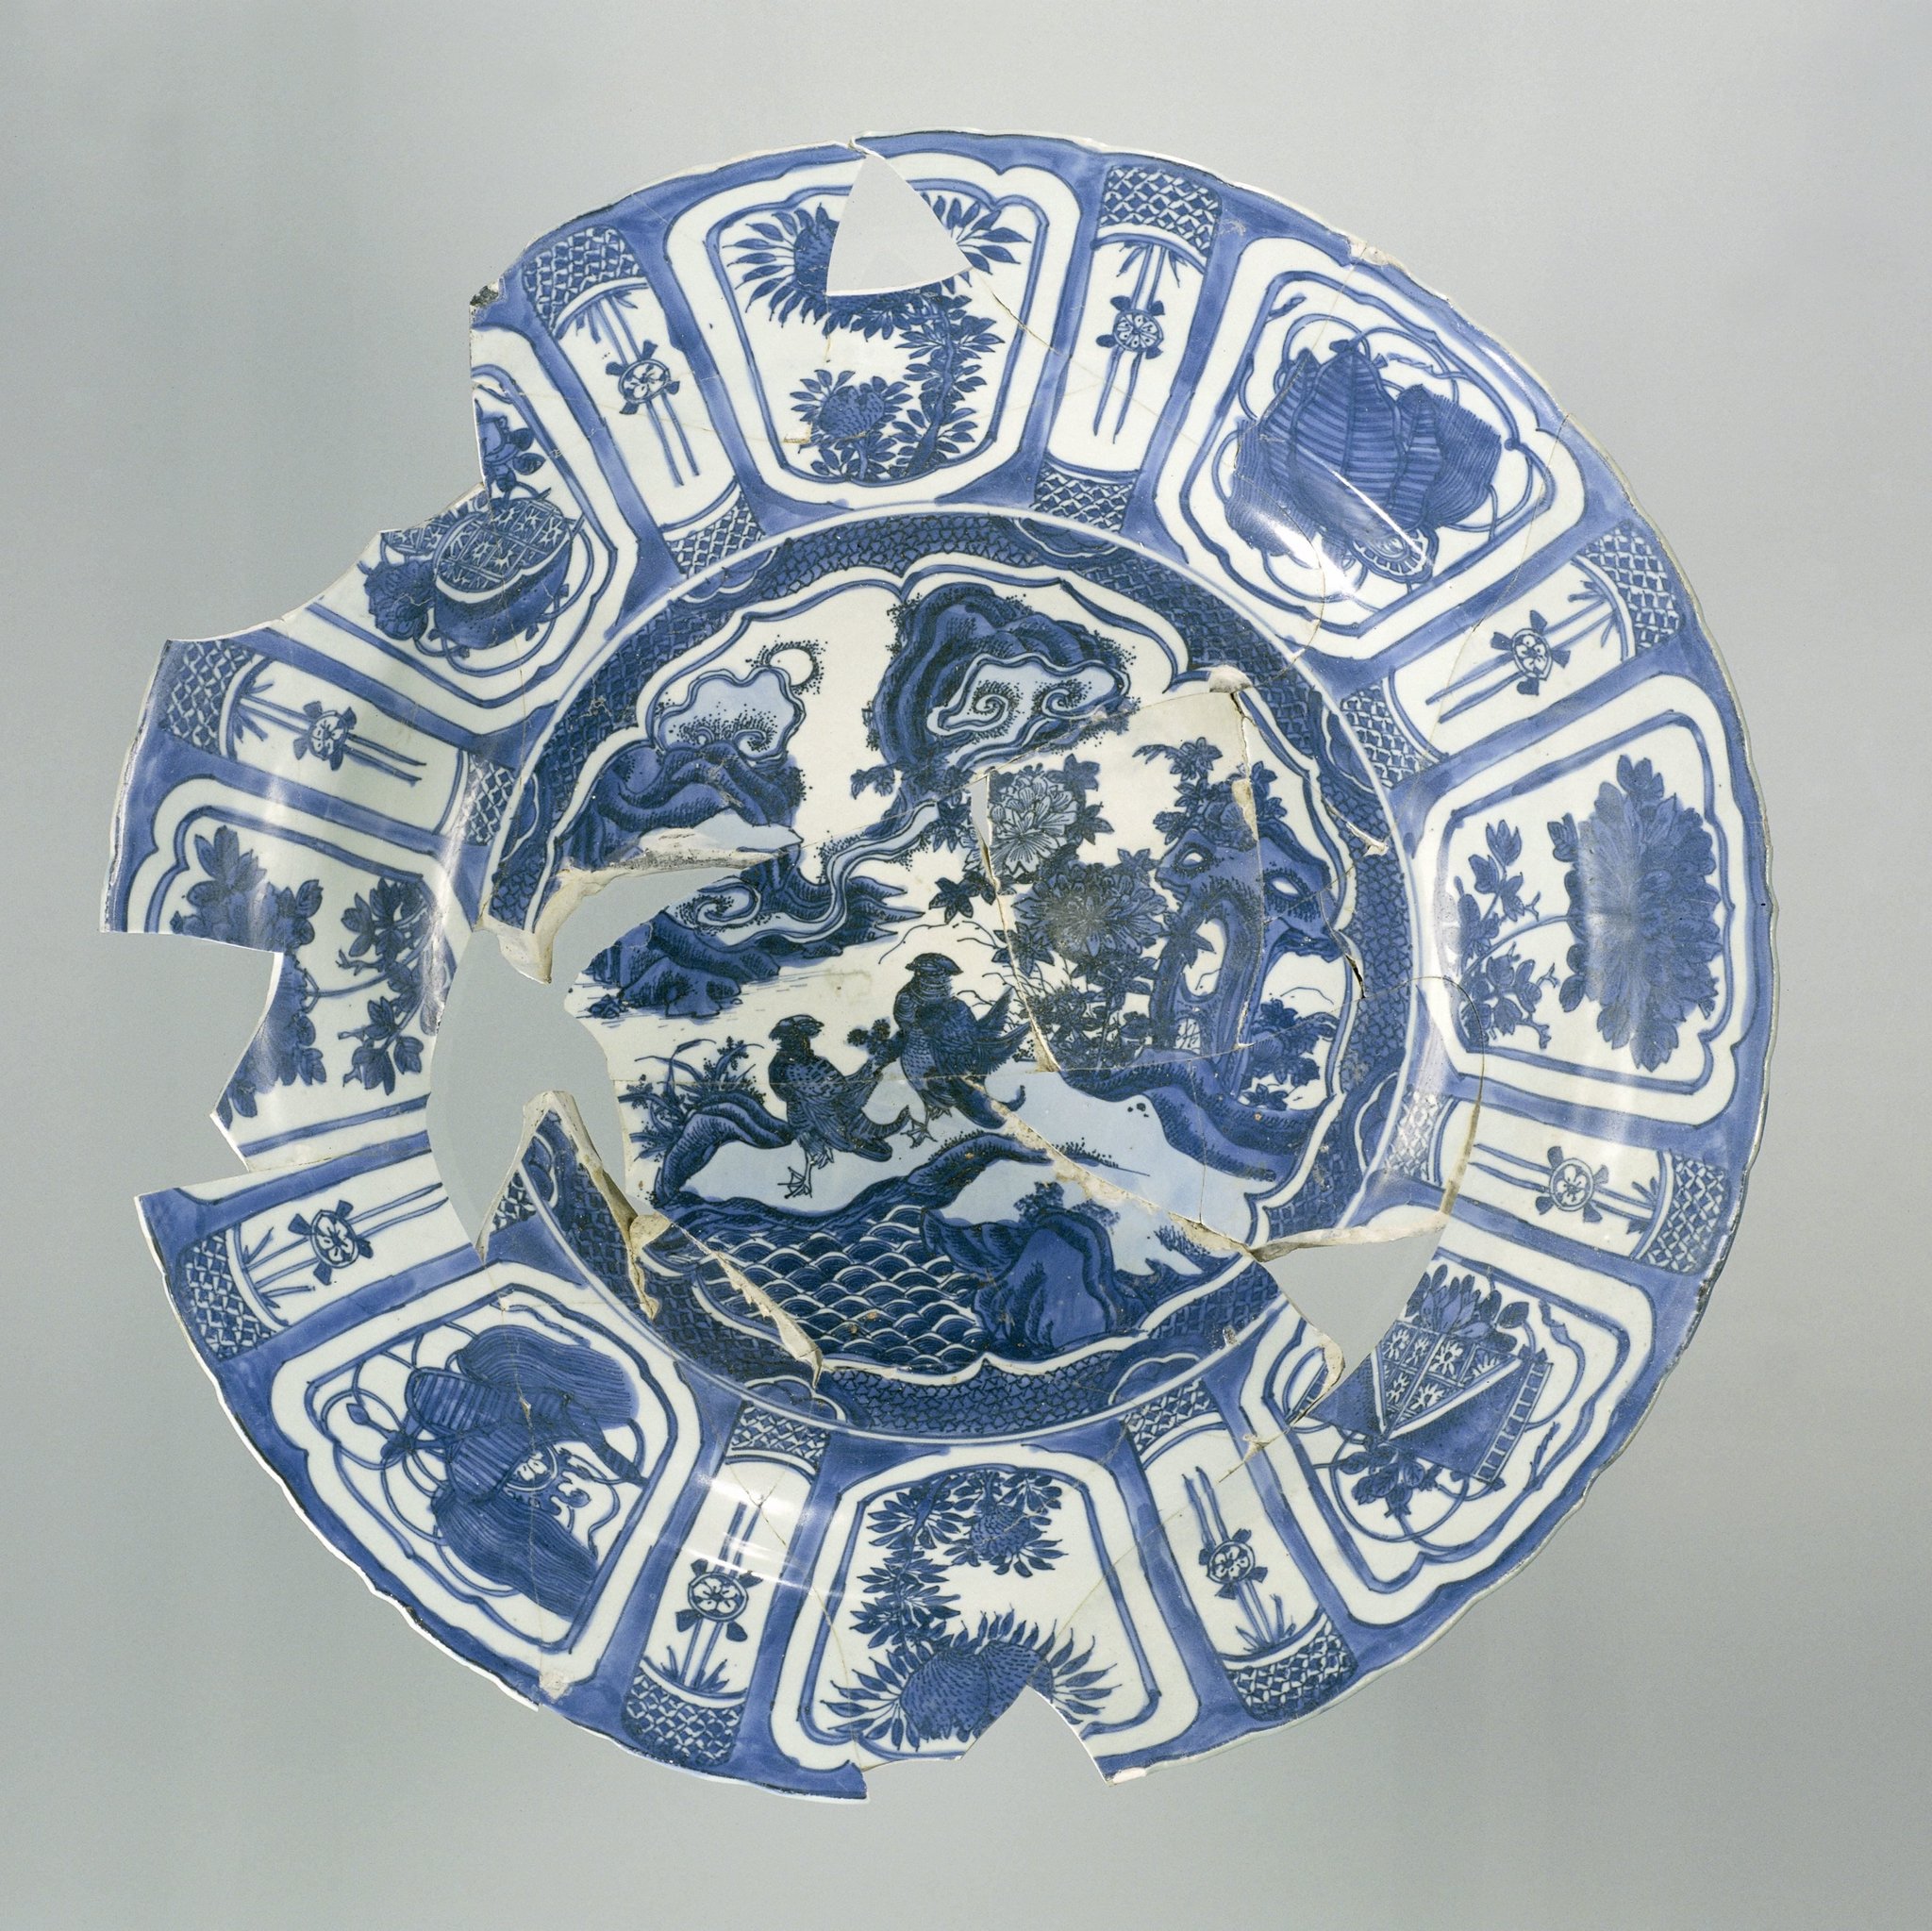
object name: platter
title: Schotel uit V.O.C.-schip de 'Witte Leeuw'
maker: Anonymous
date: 1613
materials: bone china, porcelain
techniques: painted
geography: jingdezhen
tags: verenigde oostindische compagnie, sint-helena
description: Schotel uit V.O.C.-schip de 'Witte Leeuw', 95 % aanwezig; delen van de wand en het plat ontbreken. Grote schotel met een platte rand en een geschulpte lip, gedecoreerd in onderglazuur blauw. In het plat twee vogels in een waterlandschap omgeven door een accoladevormige band gevuld met geometrische motieven. Op de wand en rand afwisselend brede en smalle velden met geluksymbolen, bloeiende planten en strikwerk. De scherf is glasachtig en kent weinig ingebakken vuil. Het glazuur is blauw getint. De bodem is ongeglazuurd en de voetring is recht, gefacetteerd en staat naar binnen. Er is weinig ovenzand aangetroffen. De lip is geschulpt.